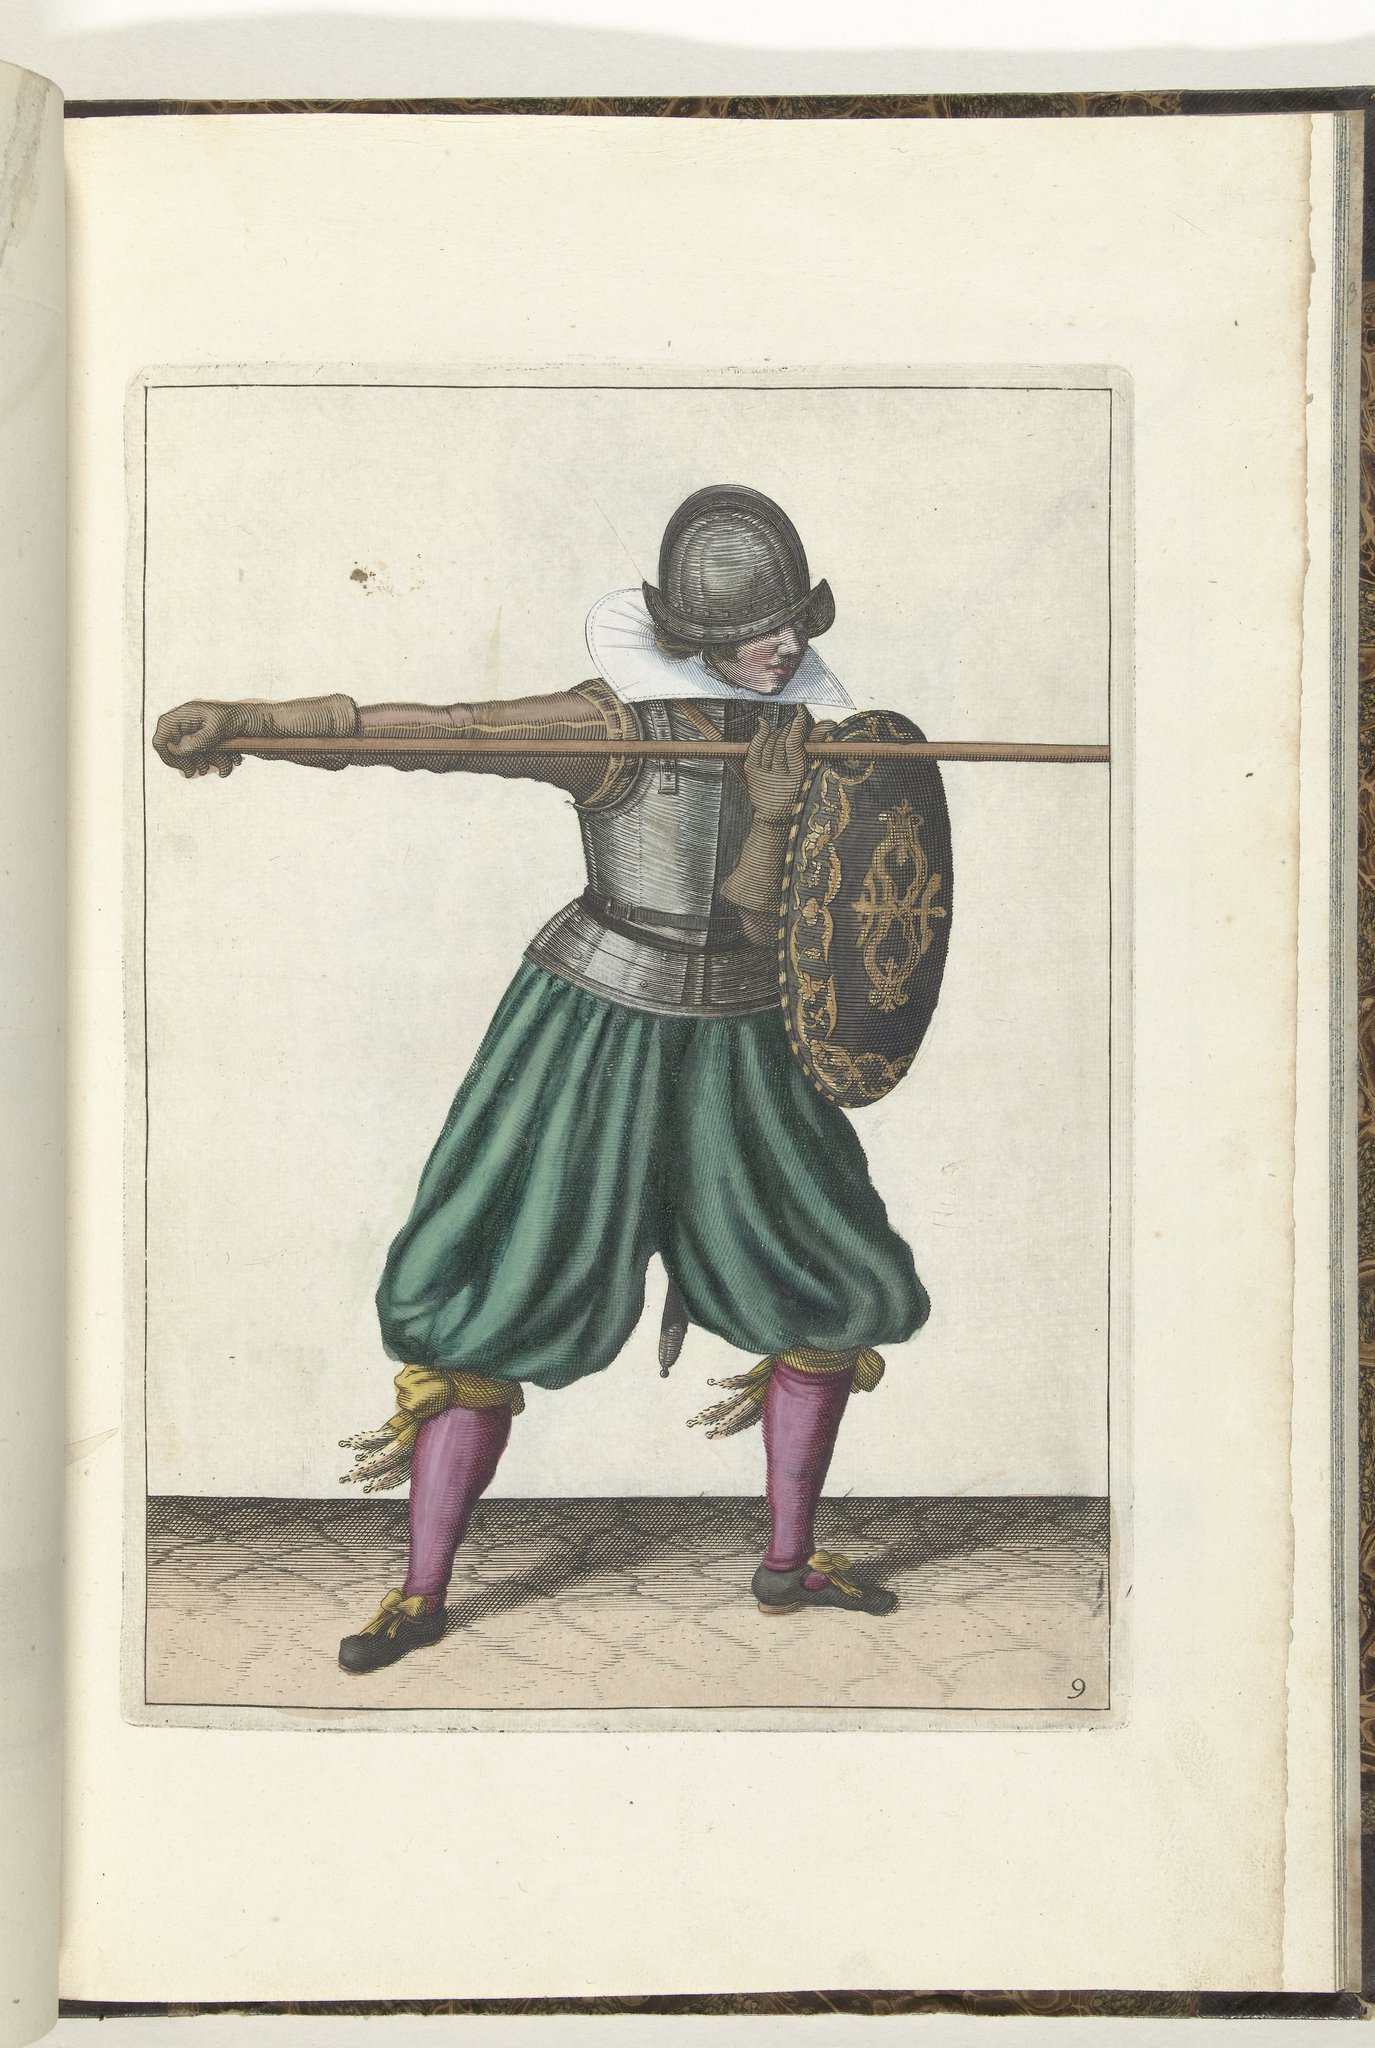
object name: print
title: De exercitie met schild en spies: de soldaat brengt in drie tijden de spies in positie, derde beweging met de spies recht vooruit (nr. 9), 1618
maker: Anonymous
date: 1616-1618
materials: paper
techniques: engraving, hand coloring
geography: northern netherlands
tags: the hague, maurice (prince of orange), handling of weapons ~ military training, weapons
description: Illustratie in: Adam van Breen, Nassauische Waffenhandelung [incompleet exemplaar], 1618?, plaat 9. Dit is een Duitse editie van Adam van Breens De Nassausche Wapen-Handelinge, van Schilt, Spies, Rappier ende Targe : beyde figuerlick afgebeelt, ende gestelt na de nieu ordening [van] ... Maurits van Nassau, 's-Gravenhage, [Aert Meuris] 1618. In het exemplaar in de collectie van de Rijksmuseum Research Library (326 F 23).